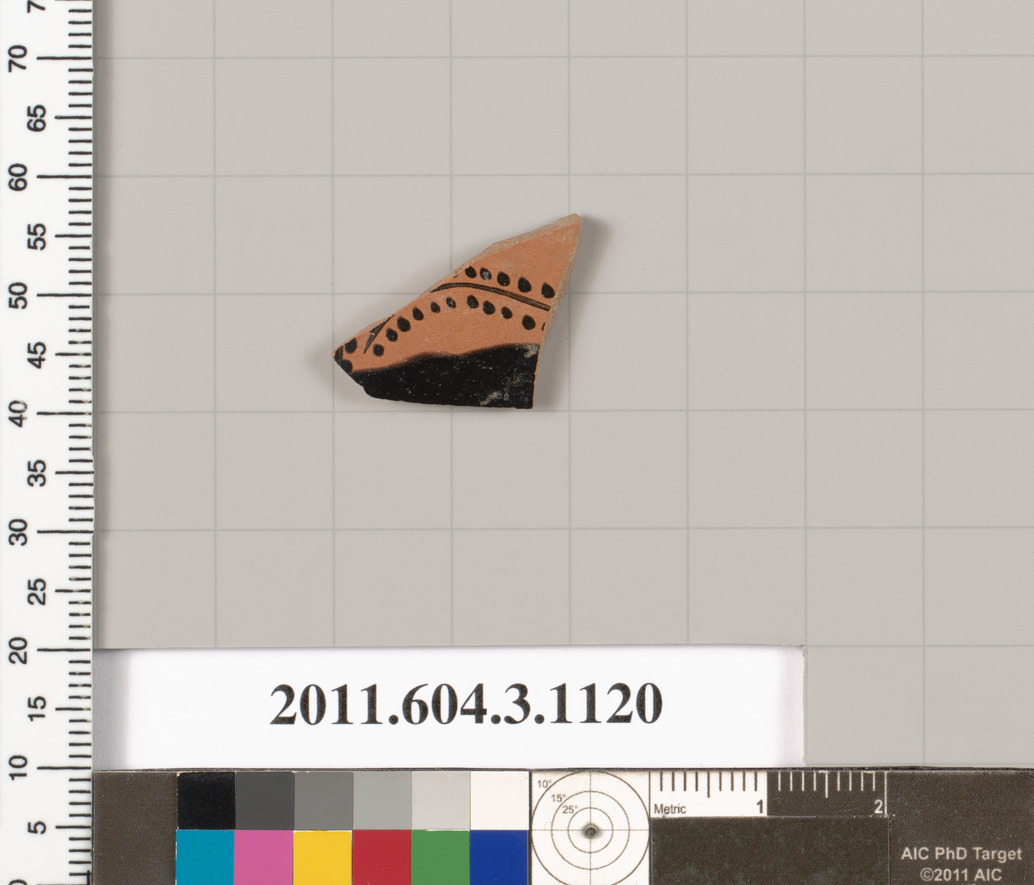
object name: mastoid or kyathos fragment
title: Terracotta fragment of a mastoid (drinking cup with narrow base) or a kyathos (cup-shaped ladle)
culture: greek, attic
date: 534-468 BCE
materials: terracotta